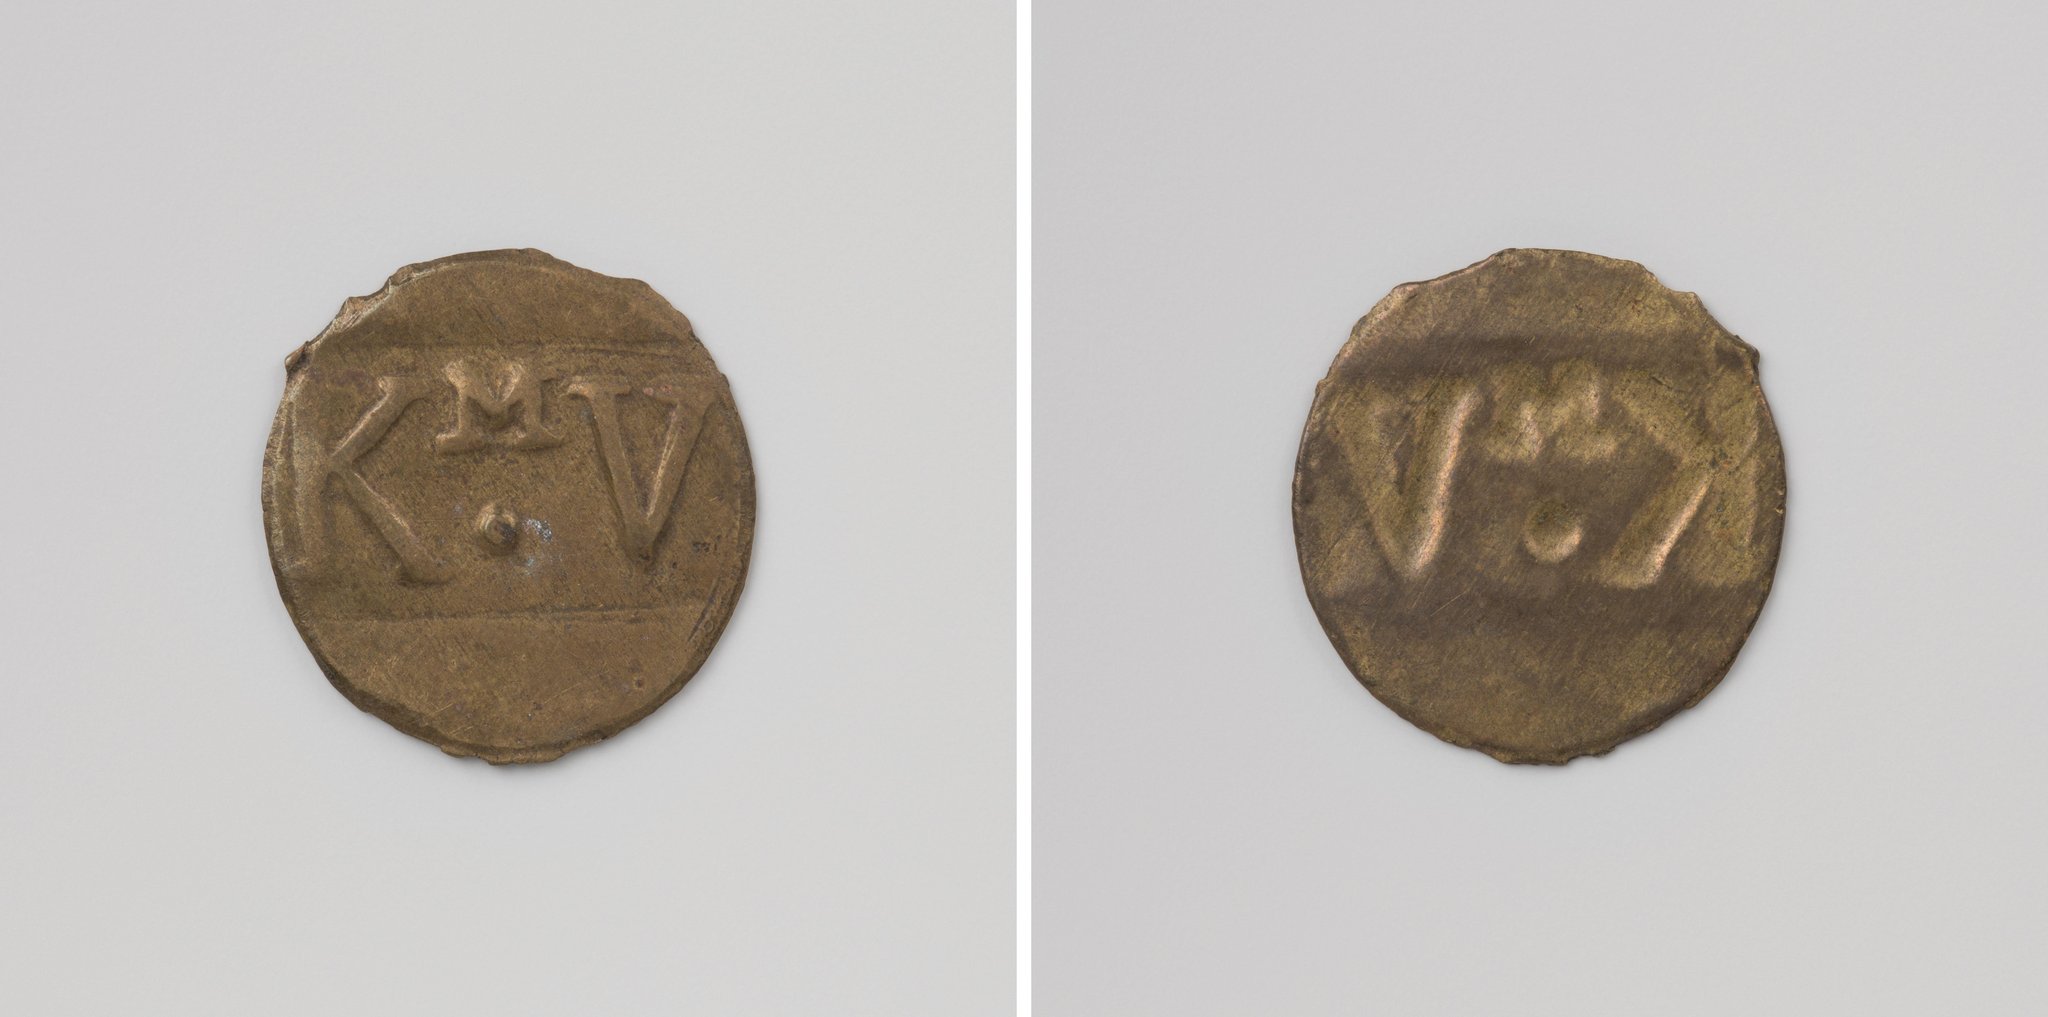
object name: cent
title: Kolonie Veenhuizen, huismunt geslagen op last van de Maatschappij van Weldadigheid ter waarde van 1 cent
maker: Anonymous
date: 1818-1859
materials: brass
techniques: striking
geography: netherlands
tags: maatschappij van weldadigheid, veenhuizen